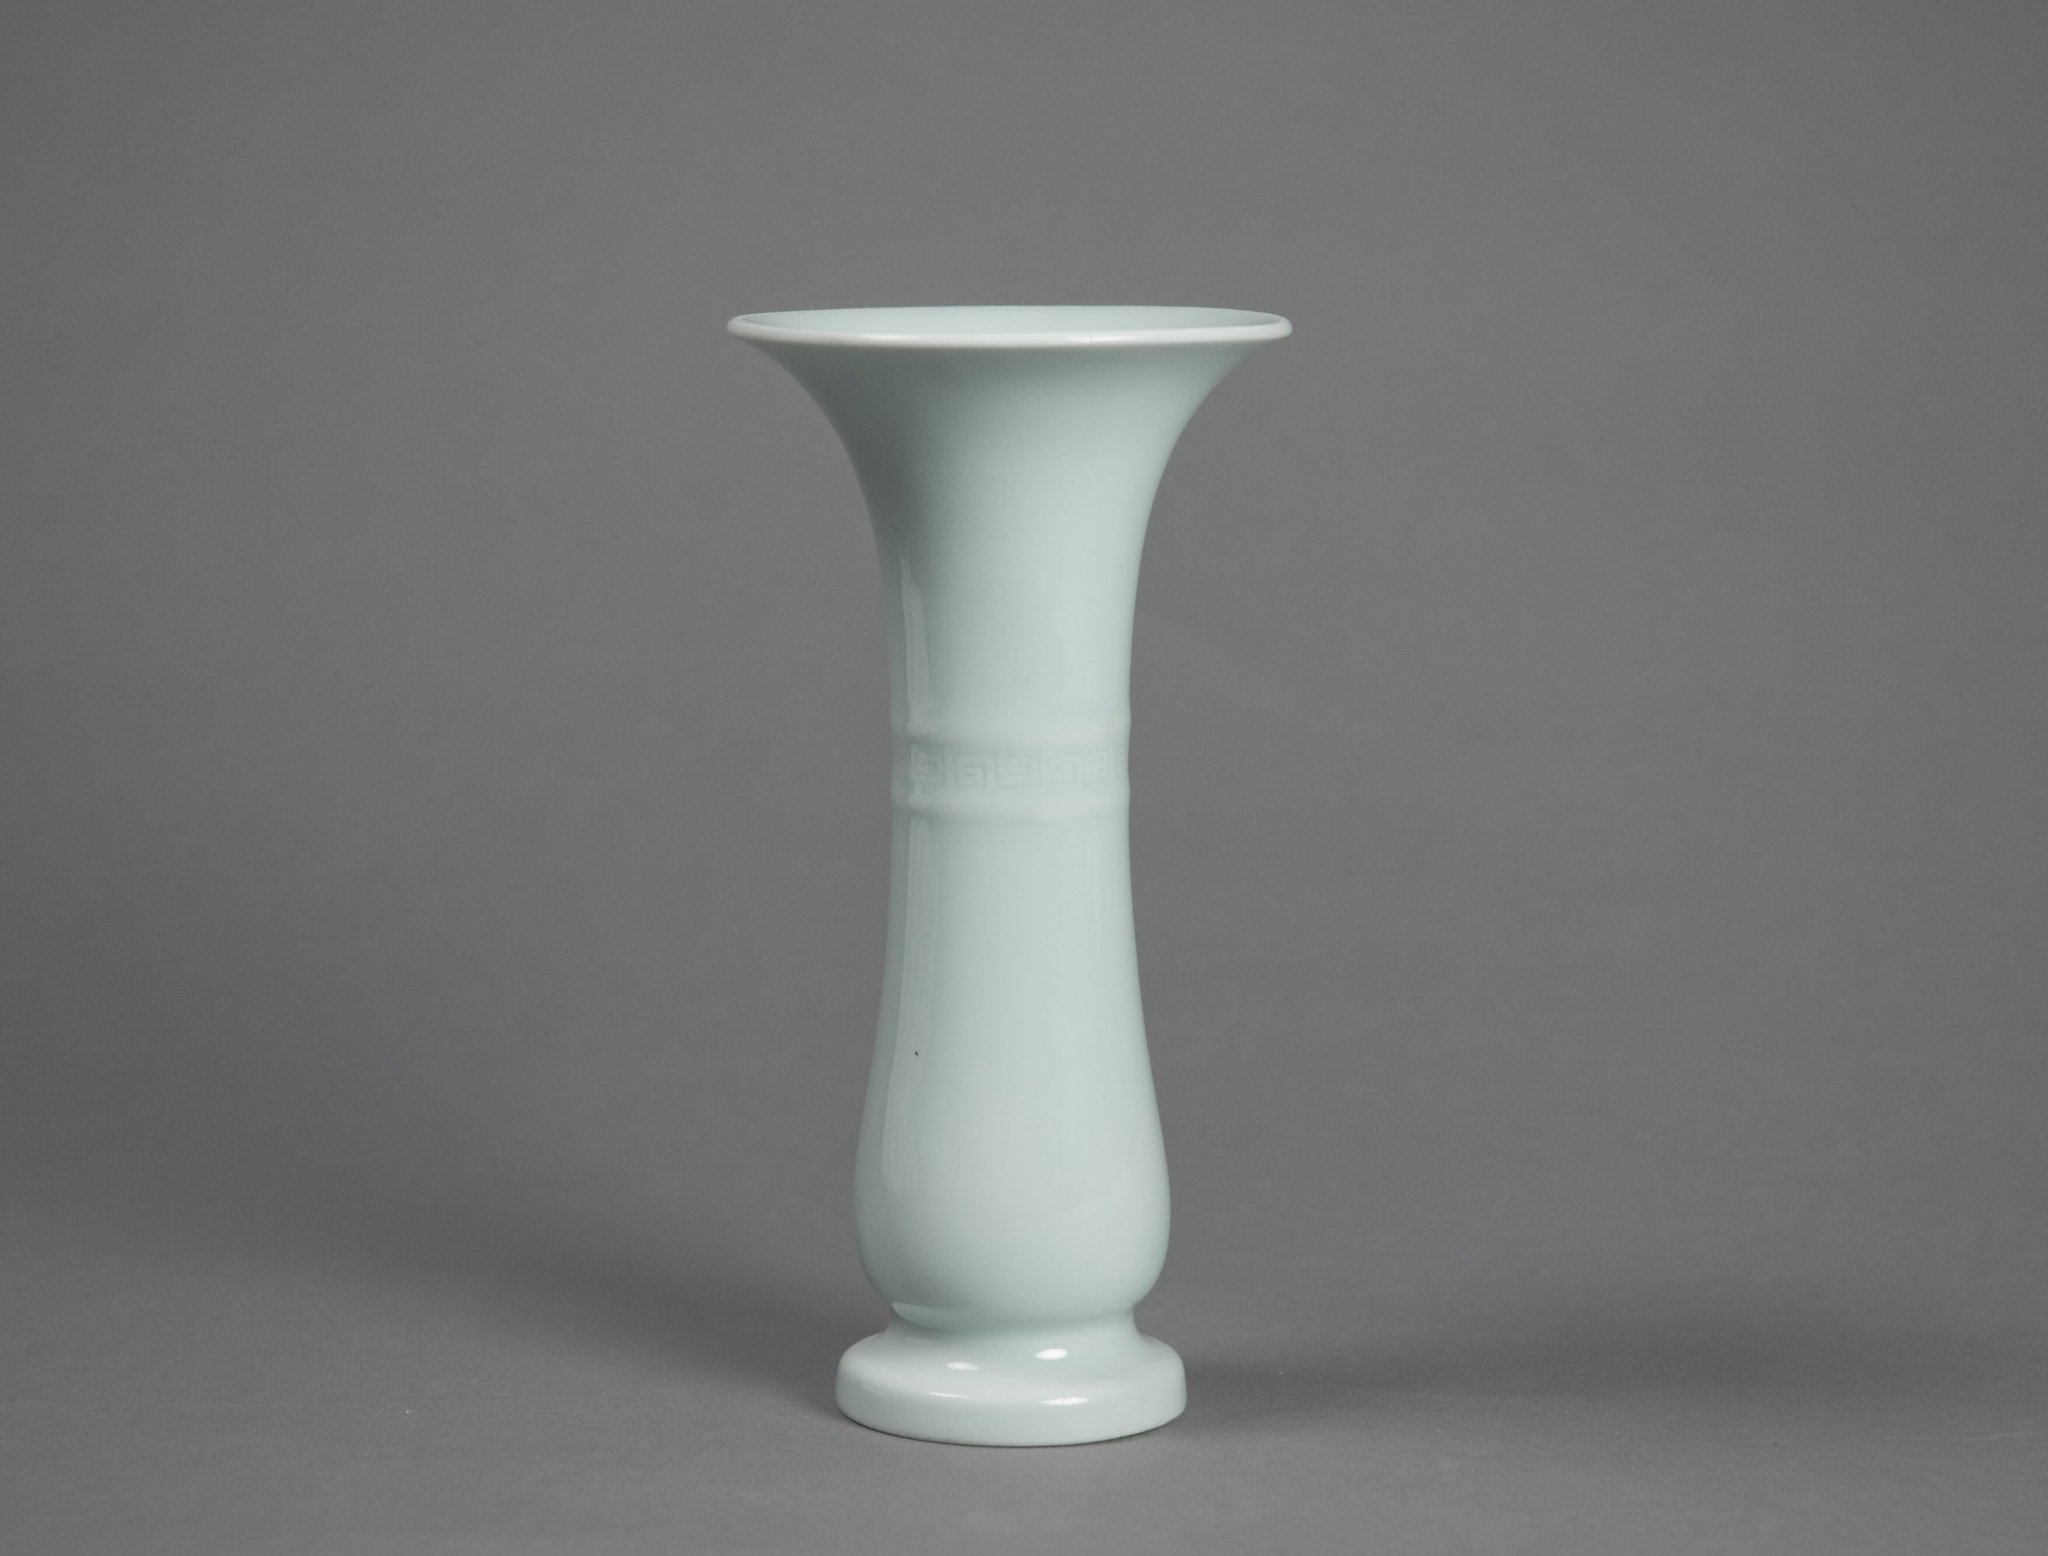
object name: vase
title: Vase in the shape of an ancient ritual cup (zhi) (one of a pair)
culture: chinese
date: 1736-1795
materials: glaze, porcelain